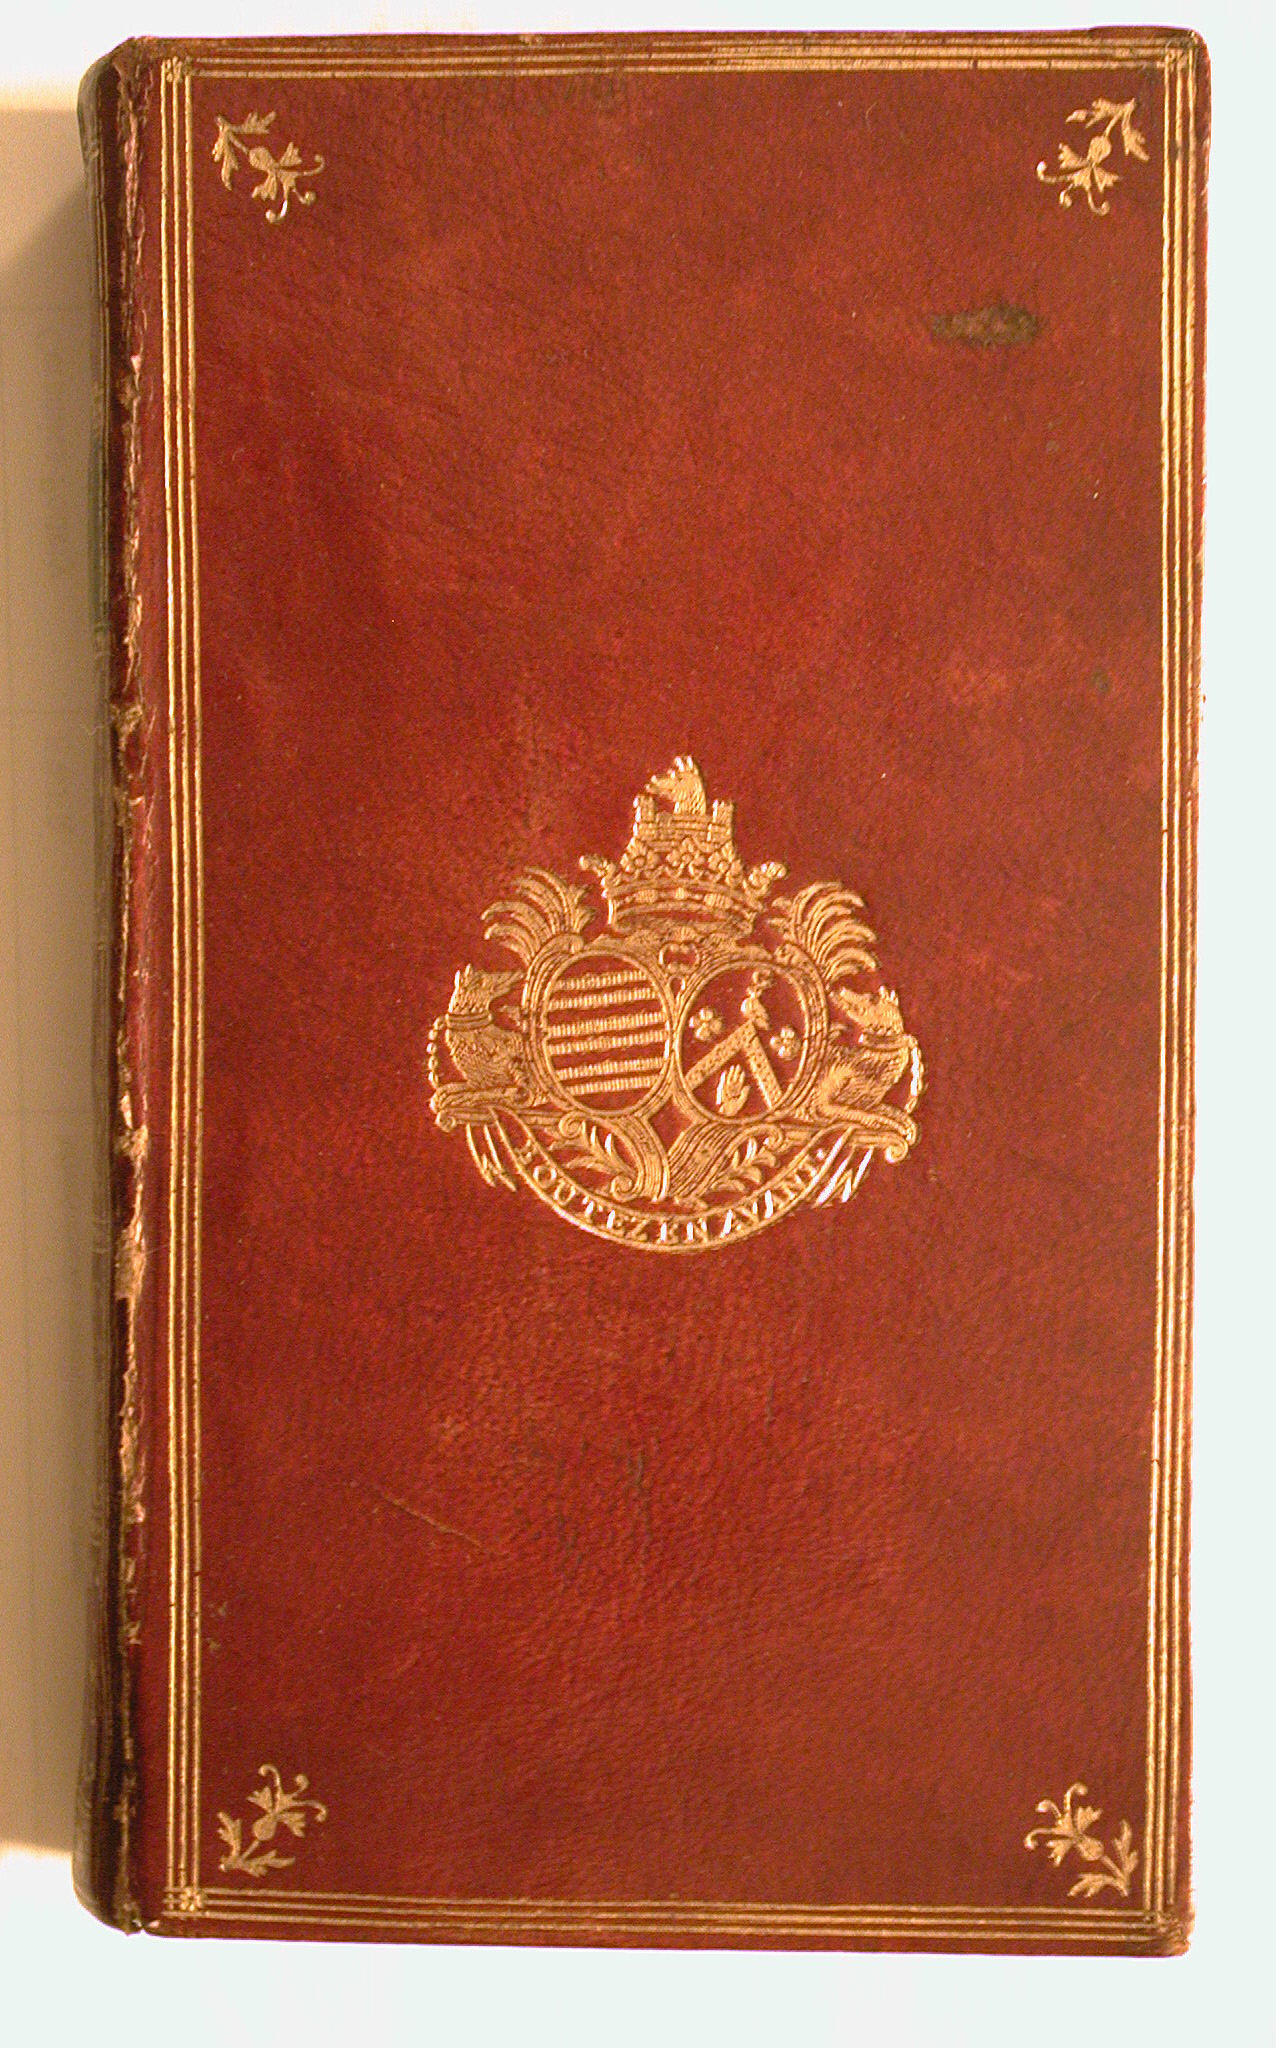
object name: book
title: Histoire du Roi Henri Le Grand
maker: hardouin de perefixe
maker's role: artist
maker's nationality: french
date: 1767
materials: leather, paper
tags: coat of arms